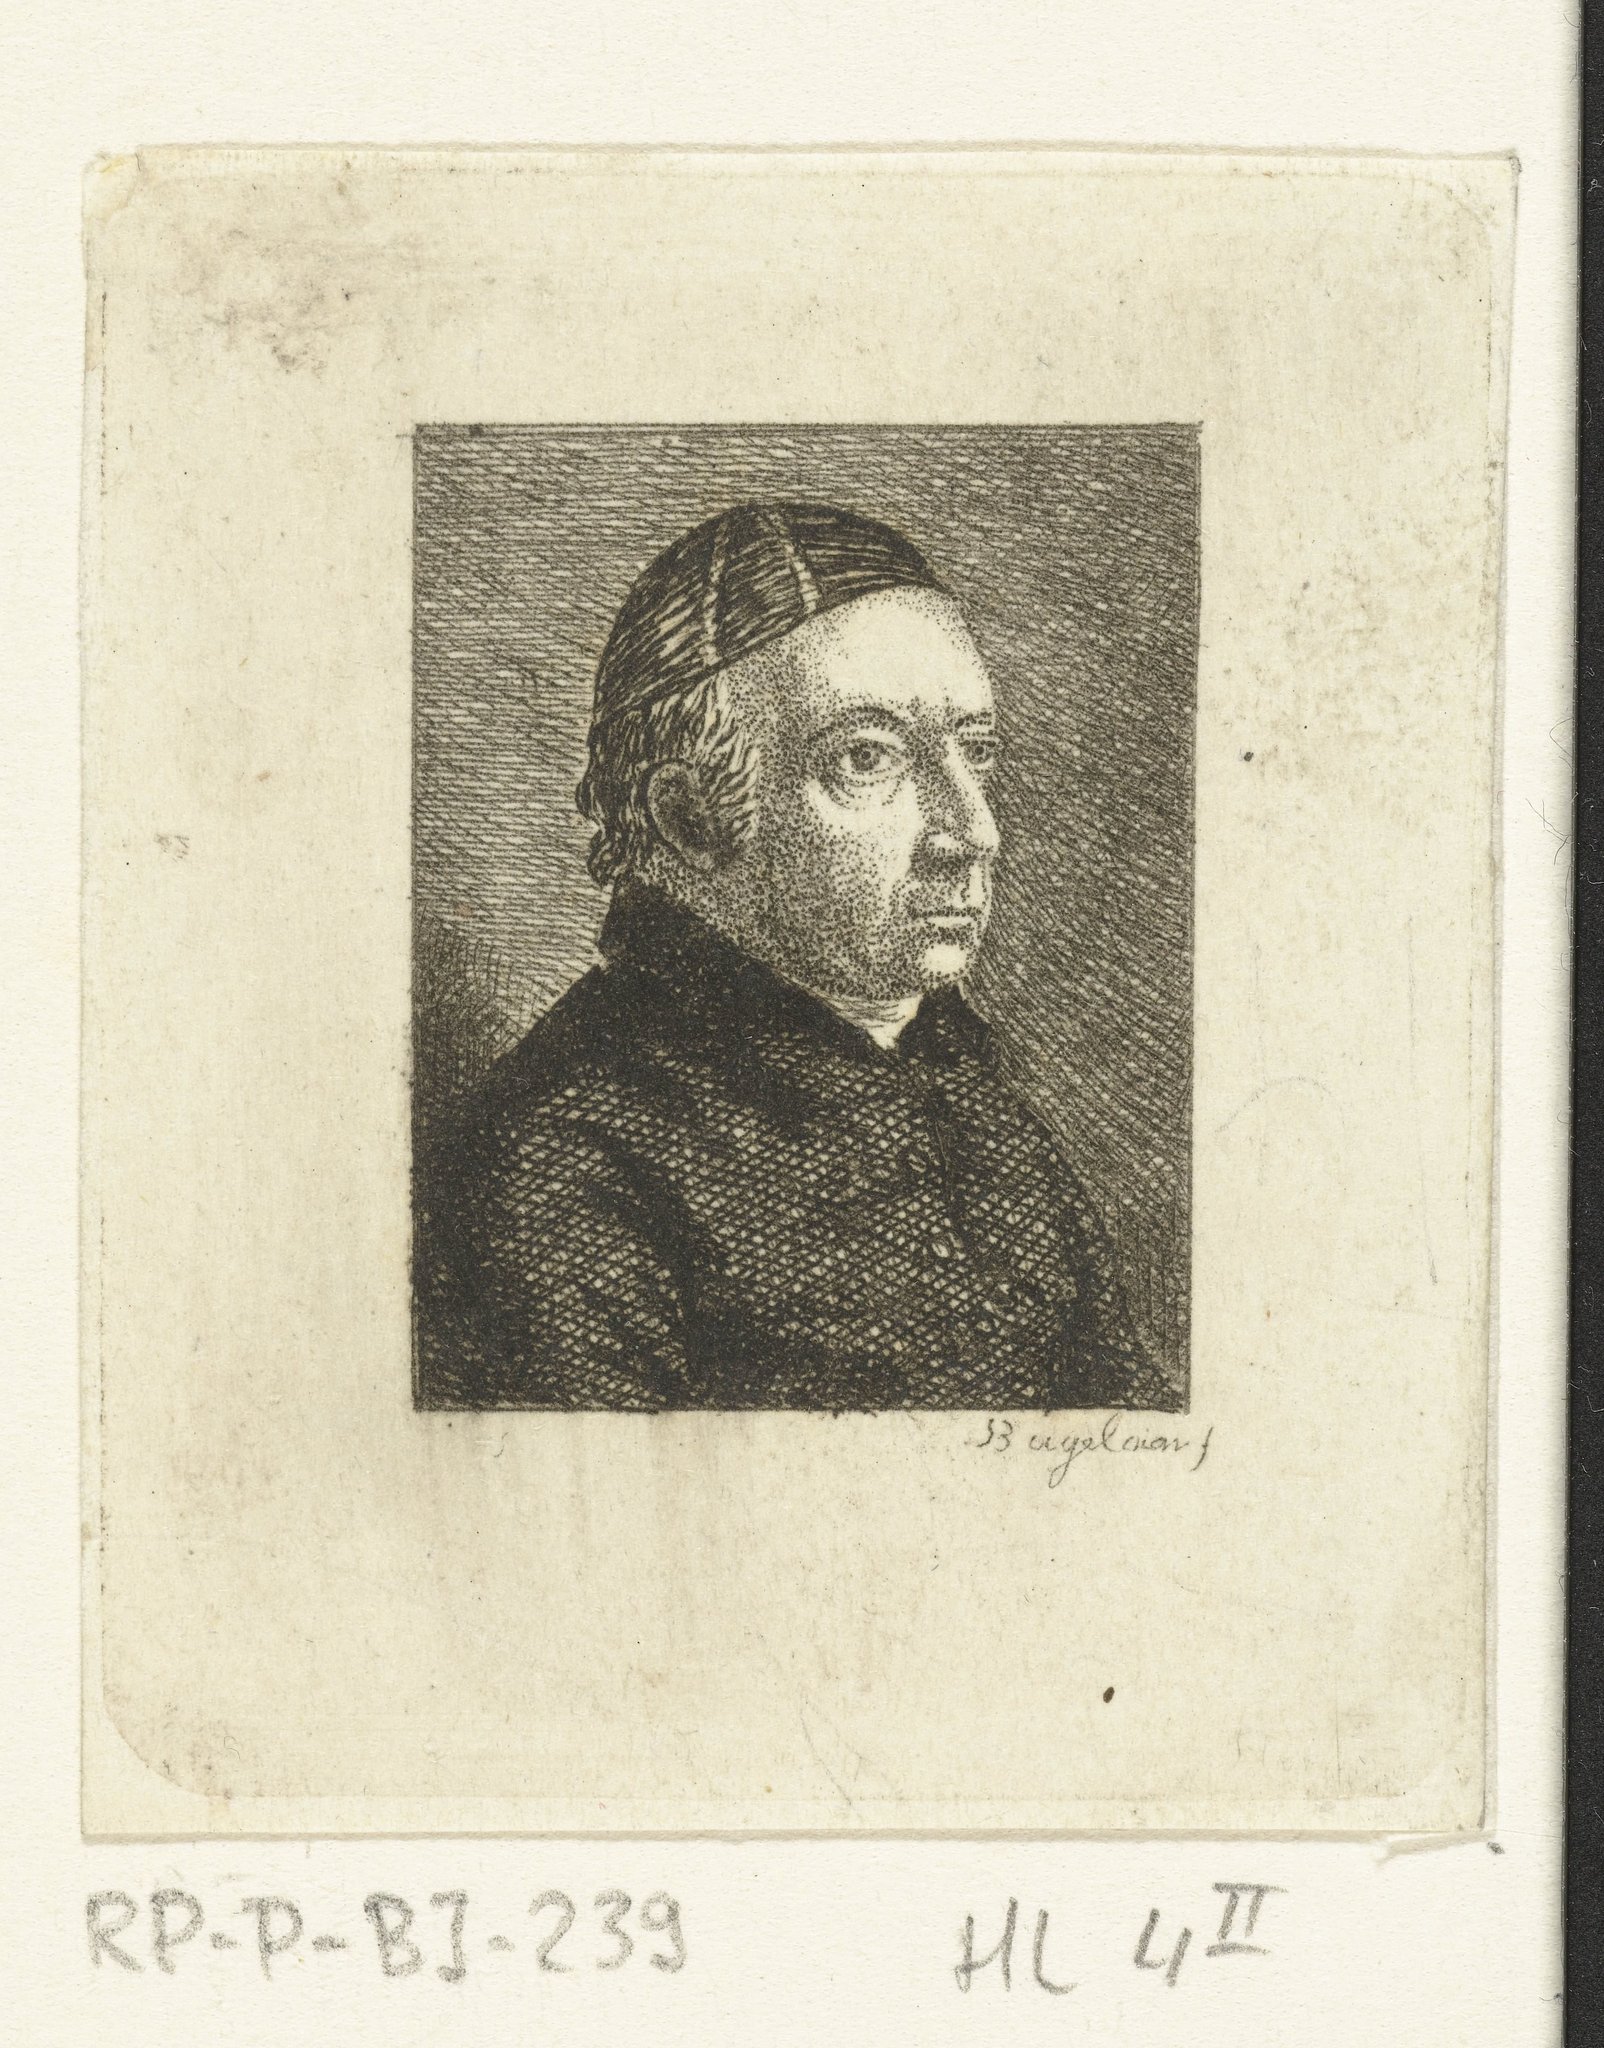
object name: print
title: Portret van de heer Hagedorn koopman uit Bremen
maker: ernst willem jan bagelaar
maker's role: draughtsman, print maker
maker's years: 1775-1837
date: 1798-1837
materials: paper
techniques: etching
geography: netherlands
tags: koopman, hermann hagedorn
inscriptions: collector's mark: Lugt 2228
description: Portretbuste van een oudere man met keppeltje.